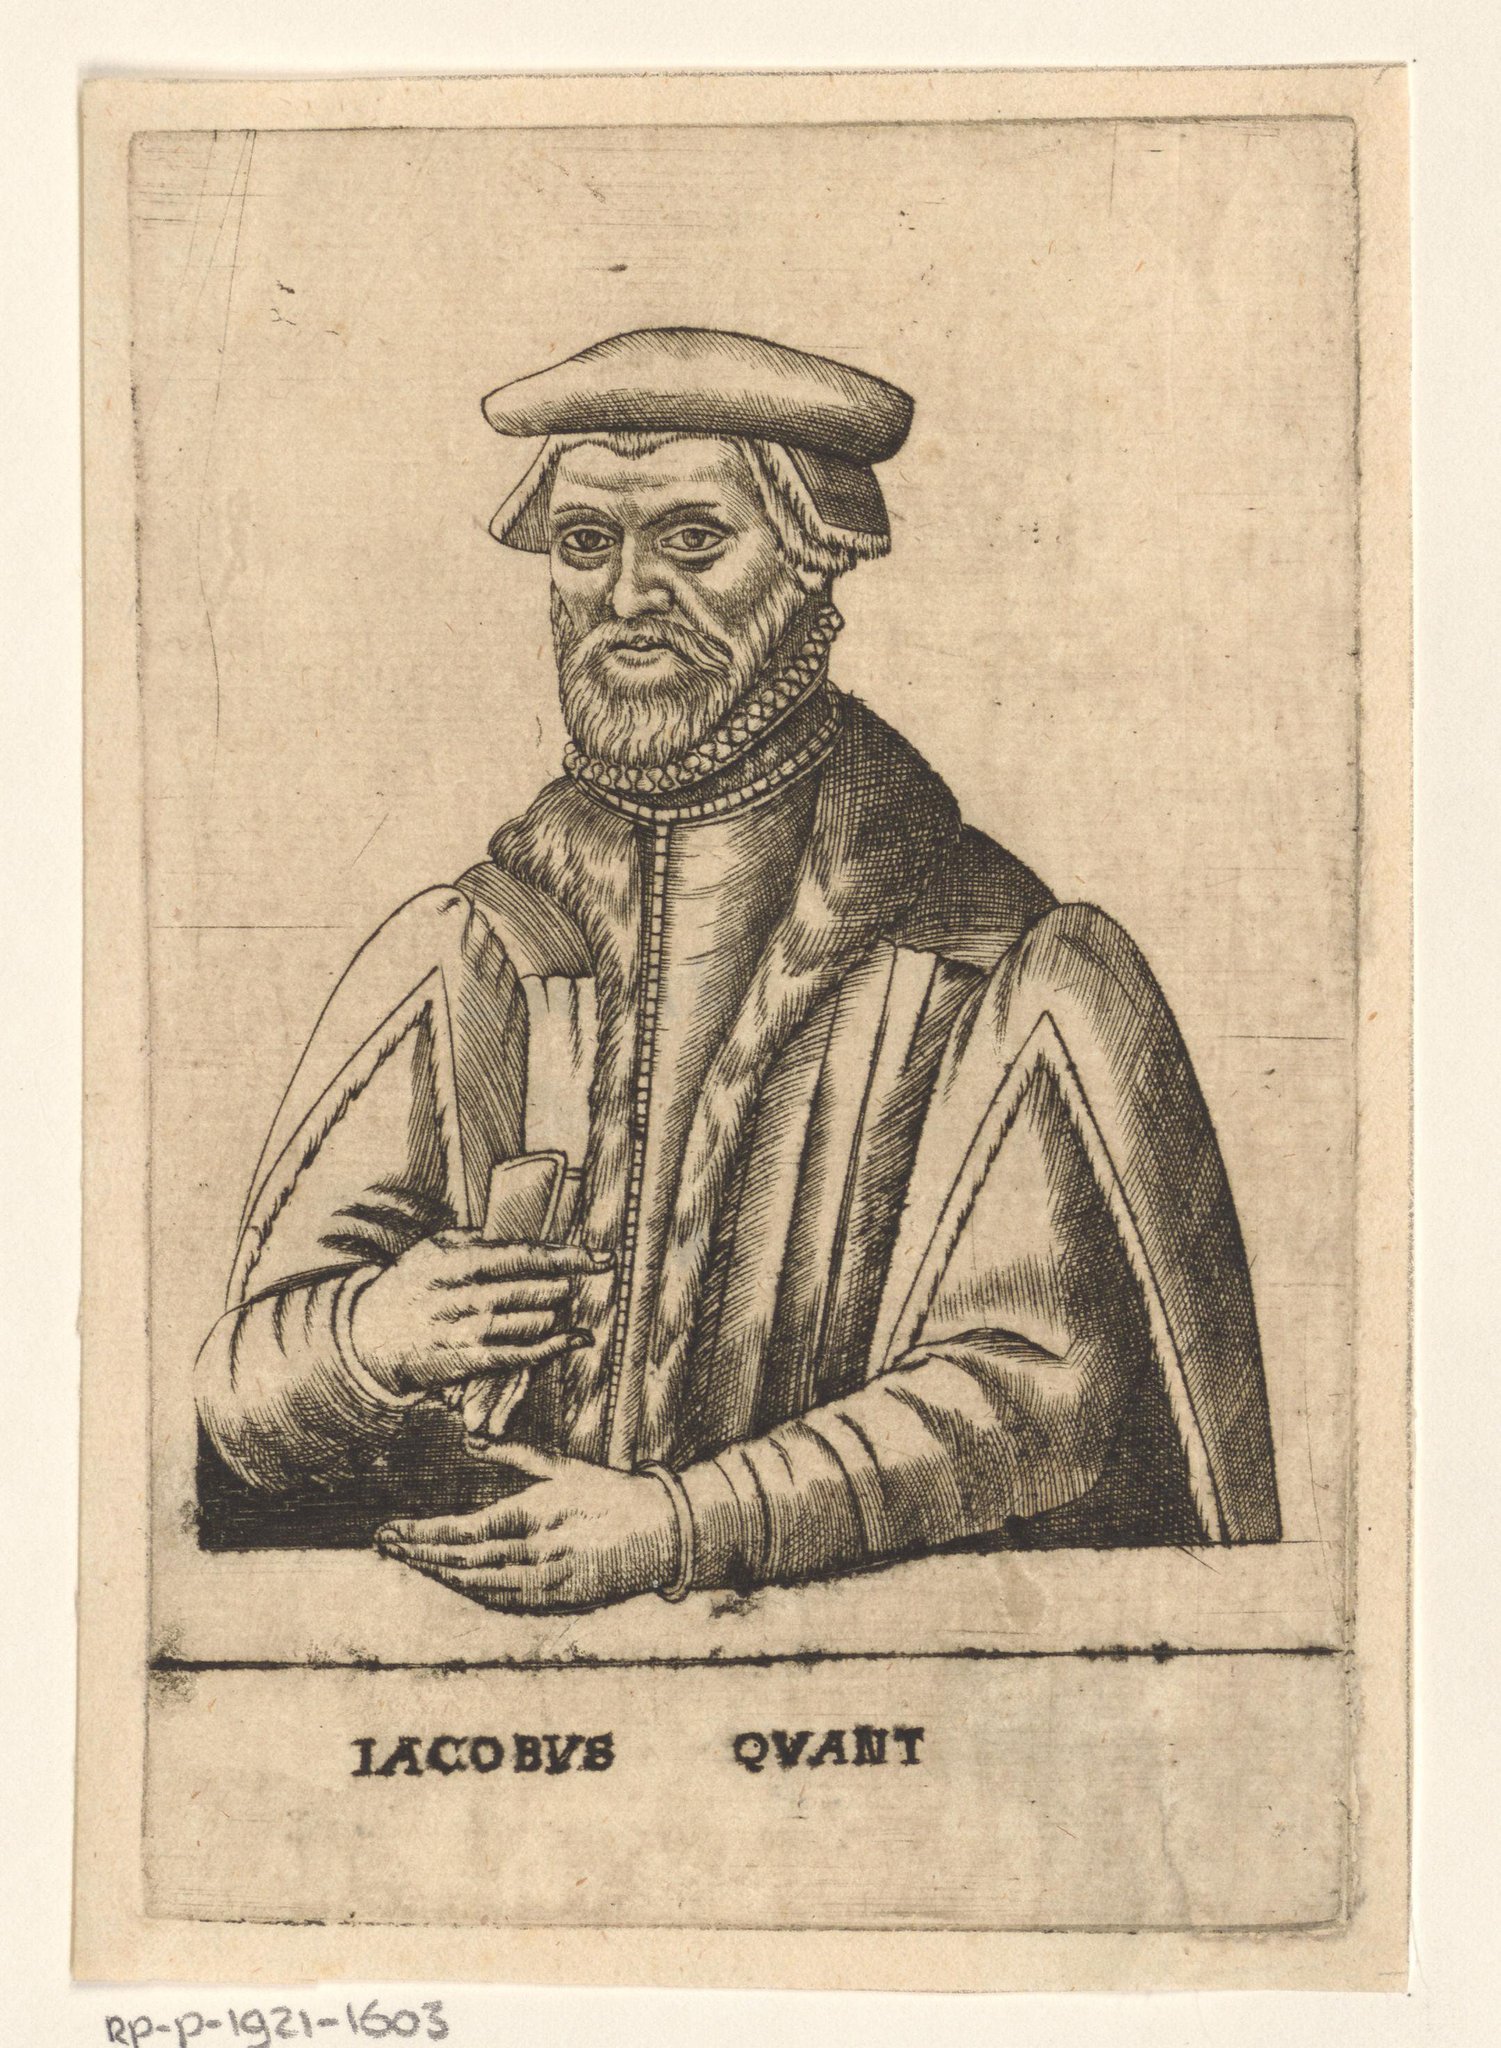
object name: print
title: Portret van Jacobus Quant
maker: Anonymous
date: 1550-1650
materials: paper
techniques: engraving, intaglio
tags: gloves, mittens, etc., historical persons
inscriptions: collector's mark: Lugt 2233